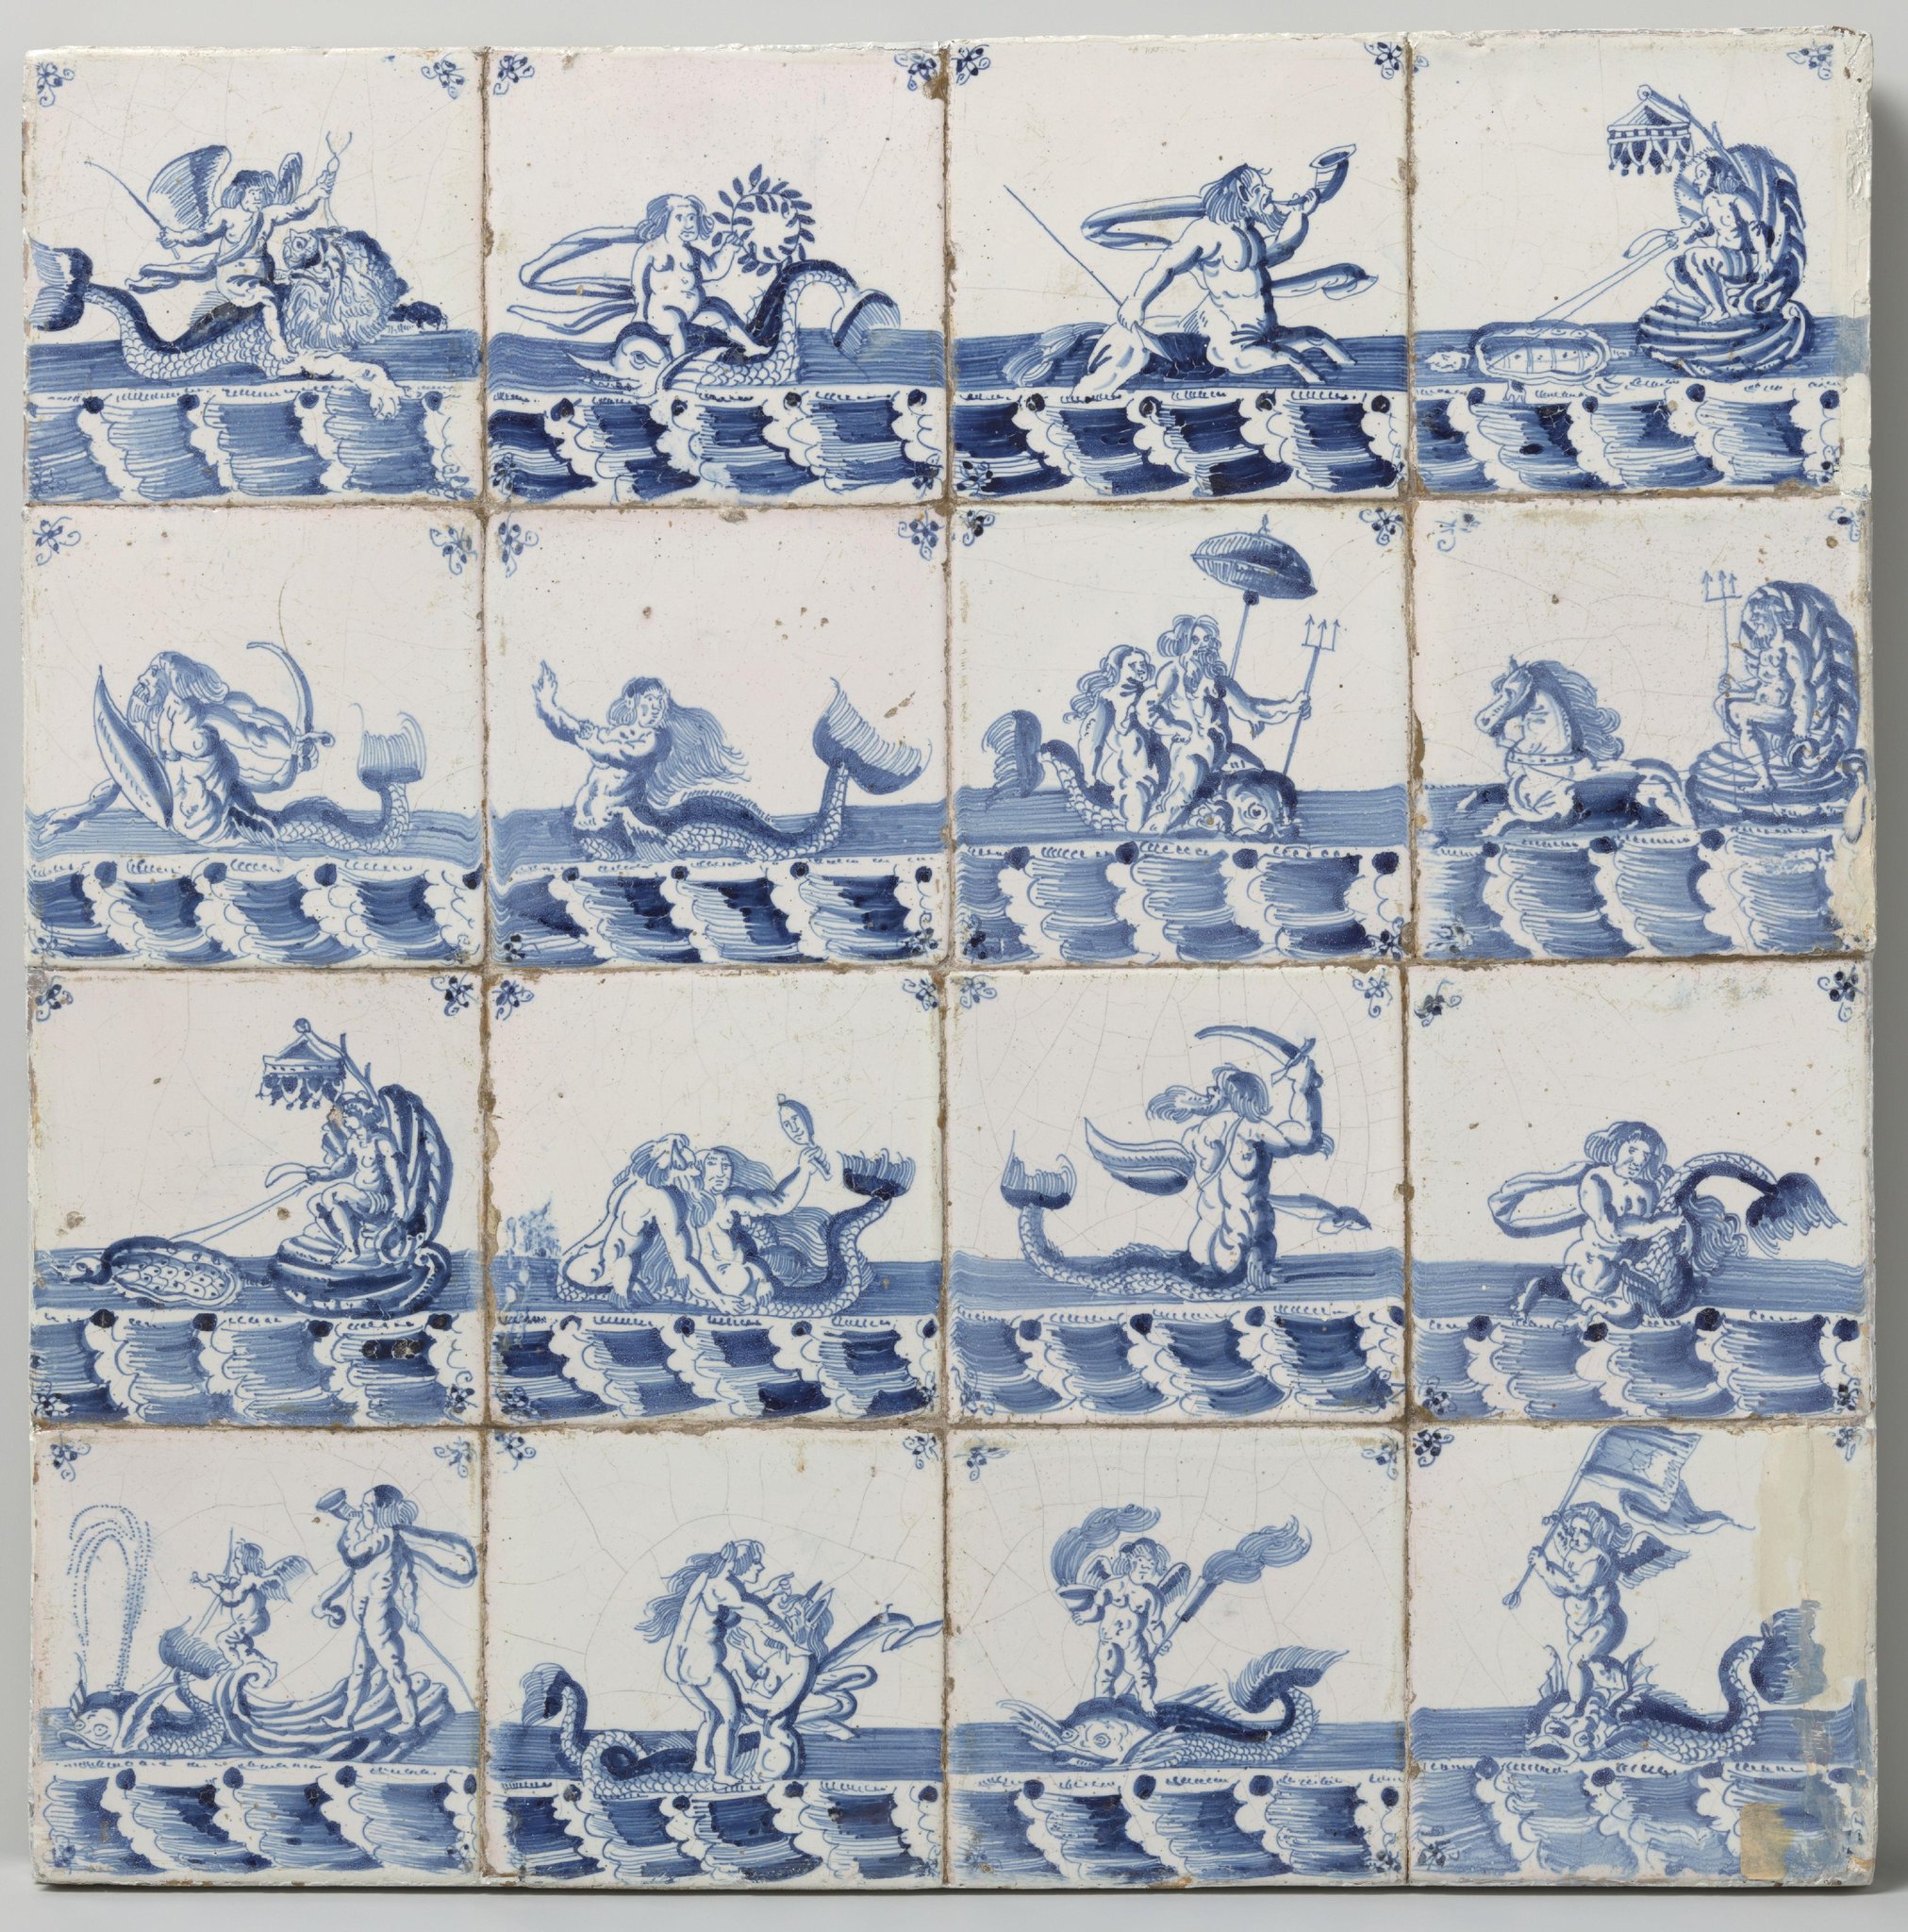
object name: tile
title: Veld van zestien tegels met zeewezens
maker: Anonymous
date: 1650-1700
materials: earthenware, glaze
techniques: maiolica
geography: netherlands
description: Veld van zestien tegels (4 x 4) elk met een blauw geschilderd zeewezen. In de hoeken, een spinnekop.